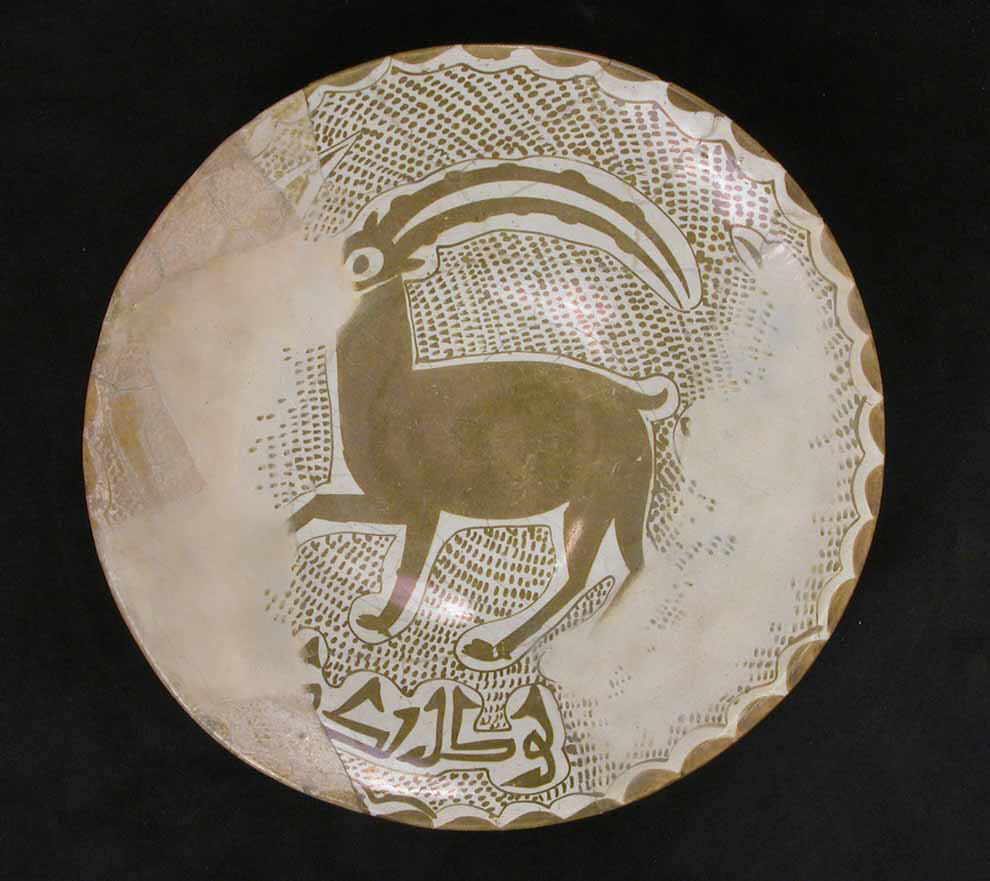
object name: bowl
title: Luster Bowl with a Ram, and “Baraka” (Blessing) Written Under the Base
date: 901-1000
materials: earthenware, glaze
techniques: luster painting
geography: iraq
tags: animals